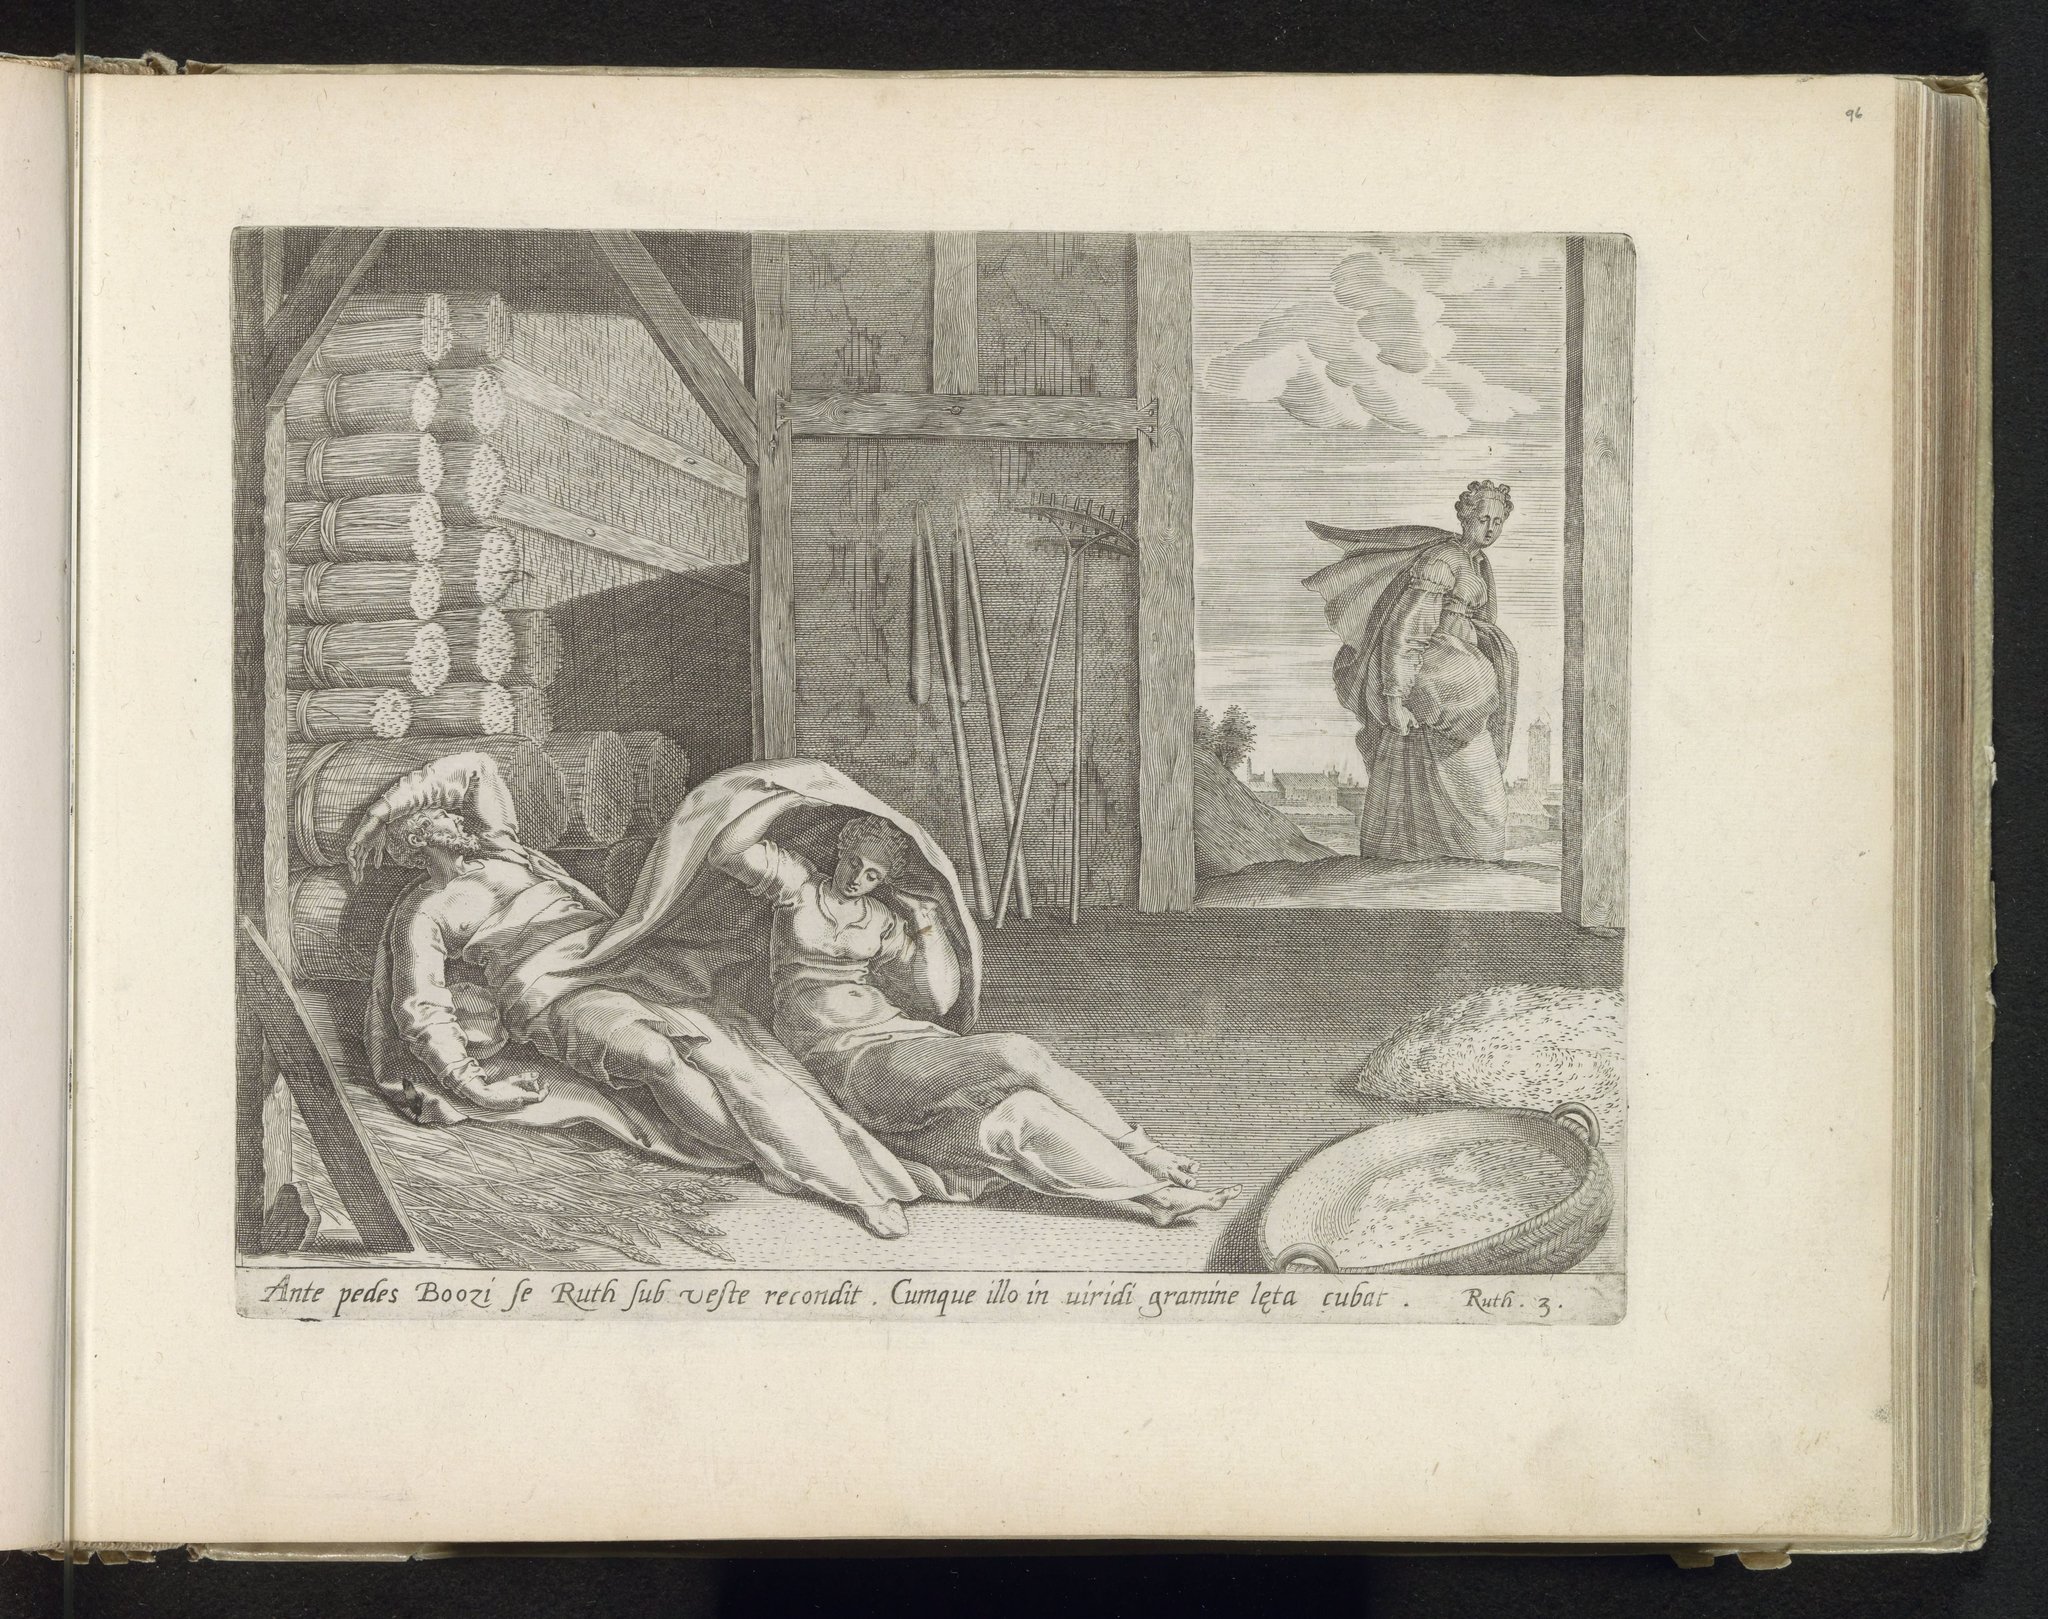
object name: album leaf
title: Ruth slaapt aan het voeteneinde van Boaz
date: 1585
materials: paper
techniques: engraving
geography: antwerp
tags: ruth uncovers the feet of the sleeping boaz and lies down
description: Boaz slaapt in een korenschuur. Ruth gaat 's nachts aan zijn voeteneinde liggen. In het ochtendgloren verlaat ze de schuur weer. Onder de voorstelling een verwijzing in het Latijn naar de Bijbeltekst in Ruth 3. Deze prent maakt deel uit van een album.